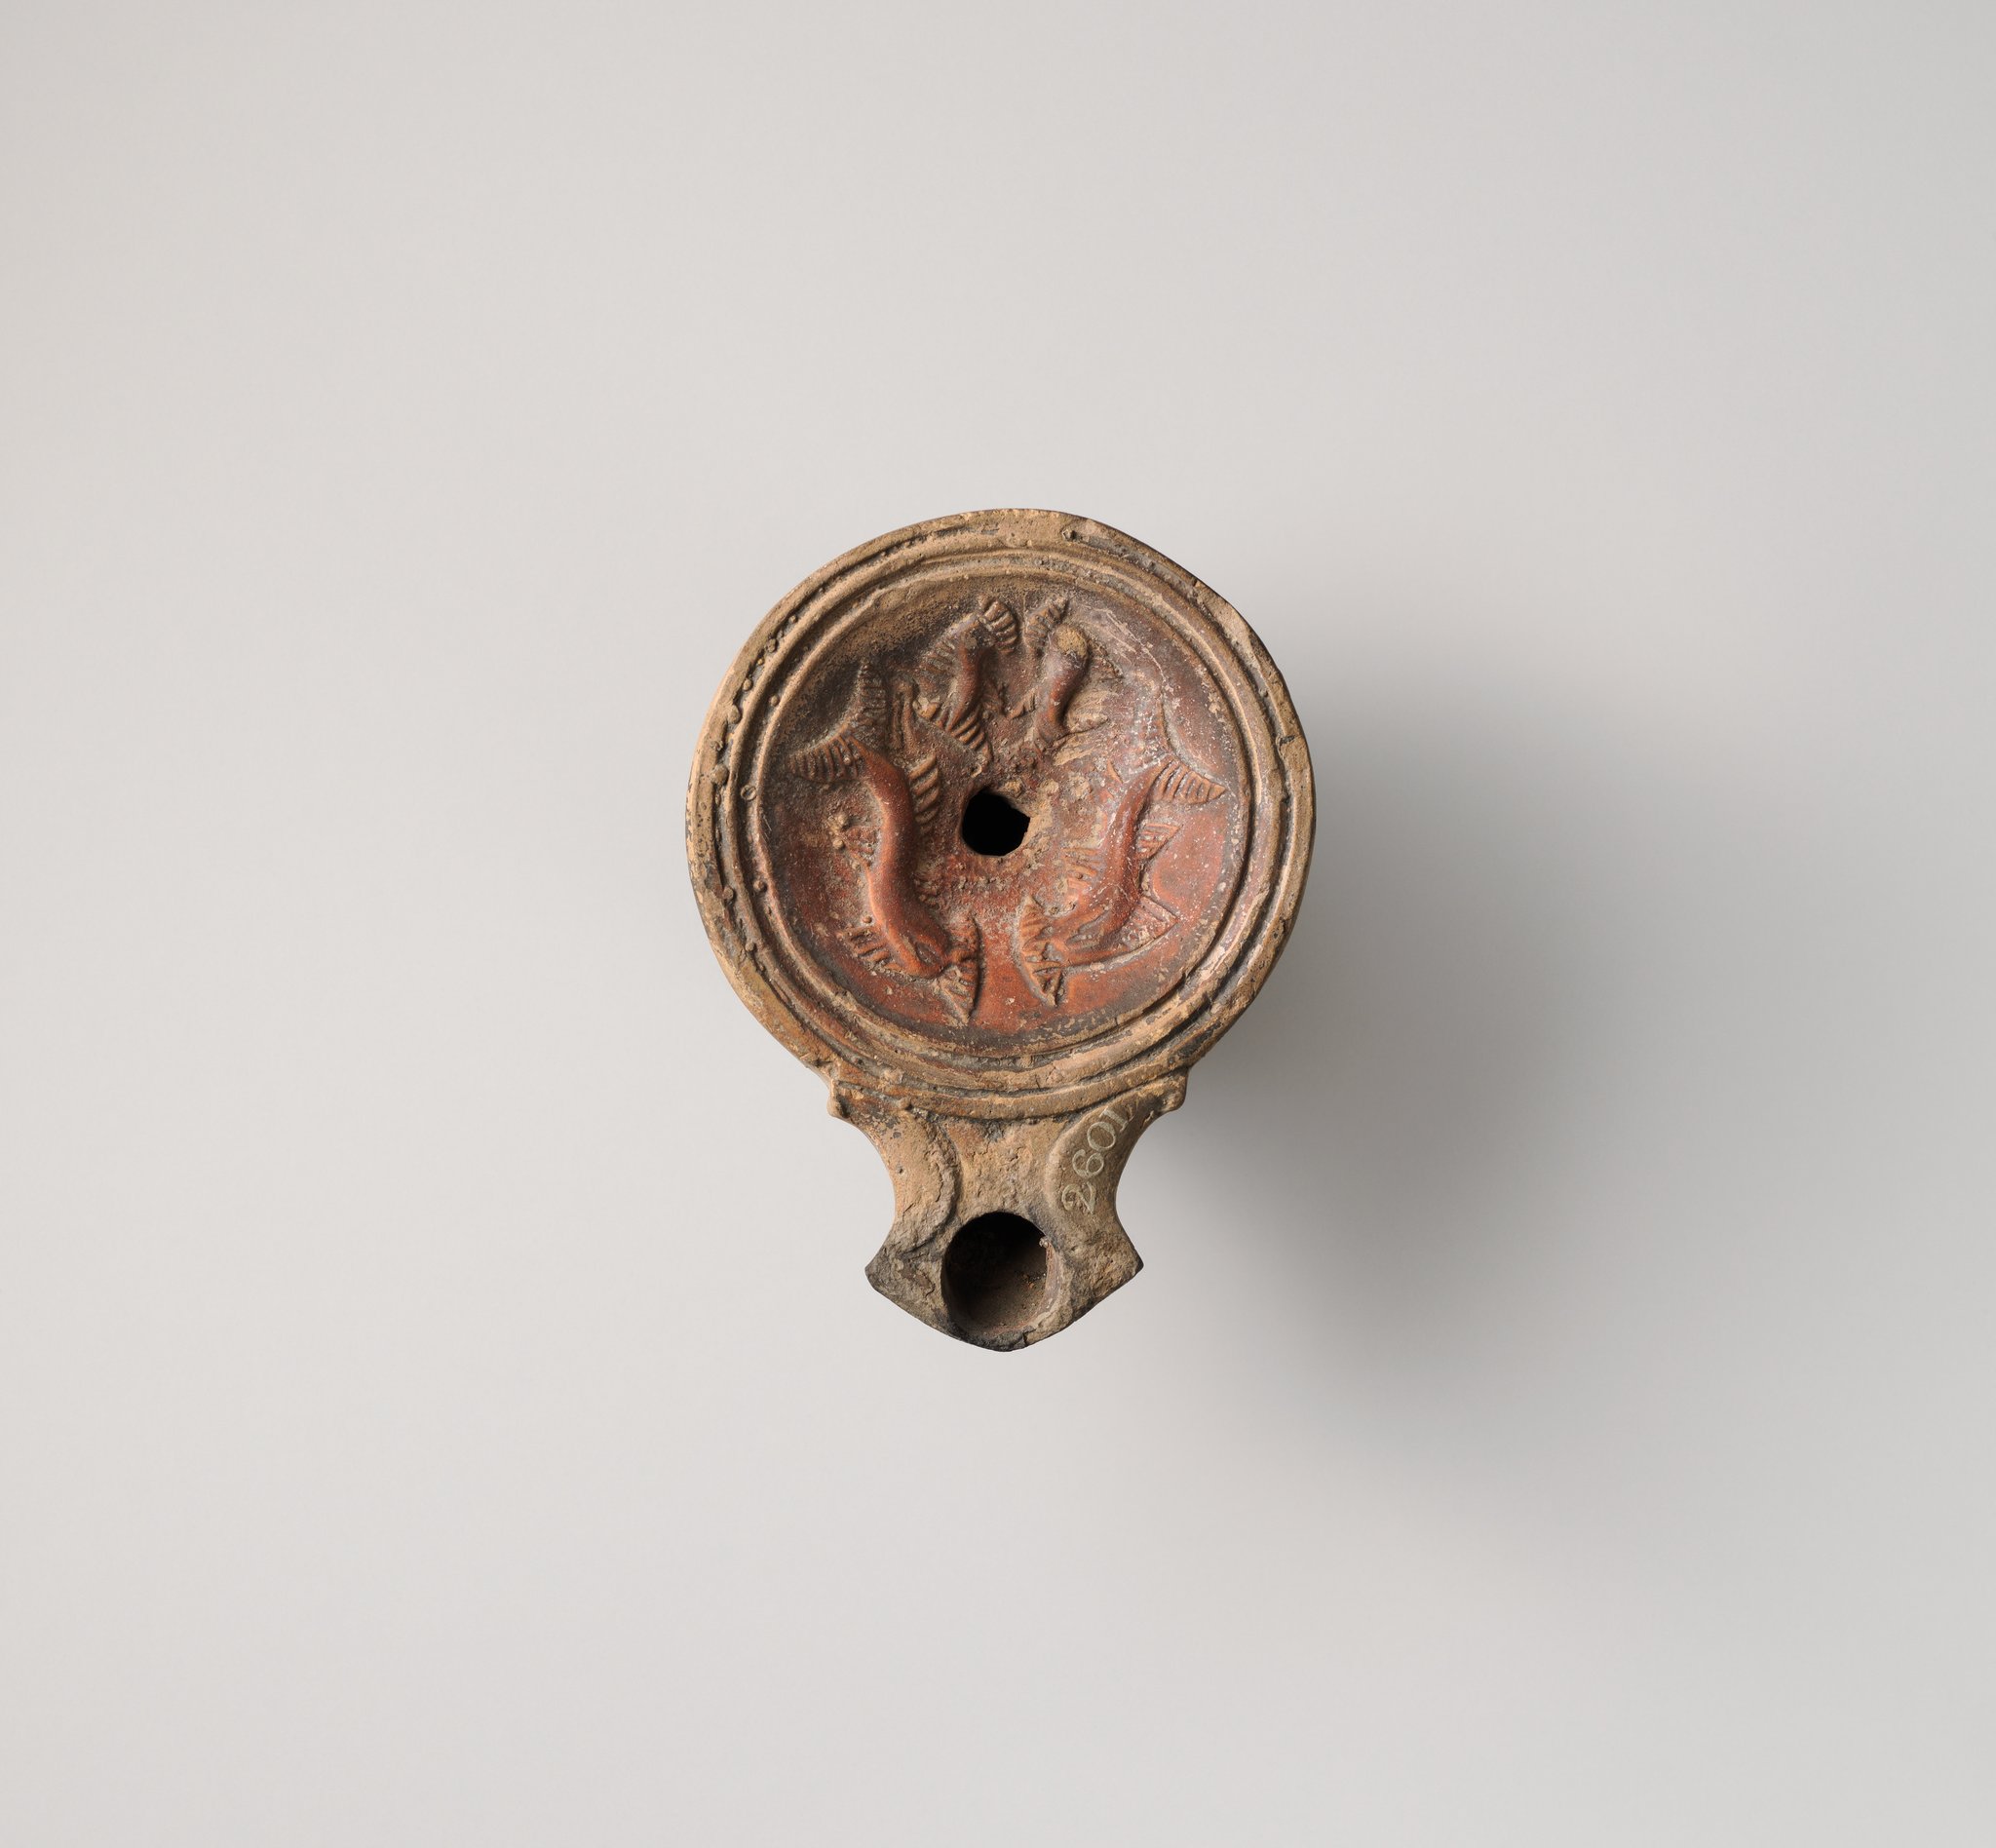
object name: lamp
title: Terracotta oil lamp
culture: roman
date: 100 BCE-100 CE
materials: terracotta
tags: fish